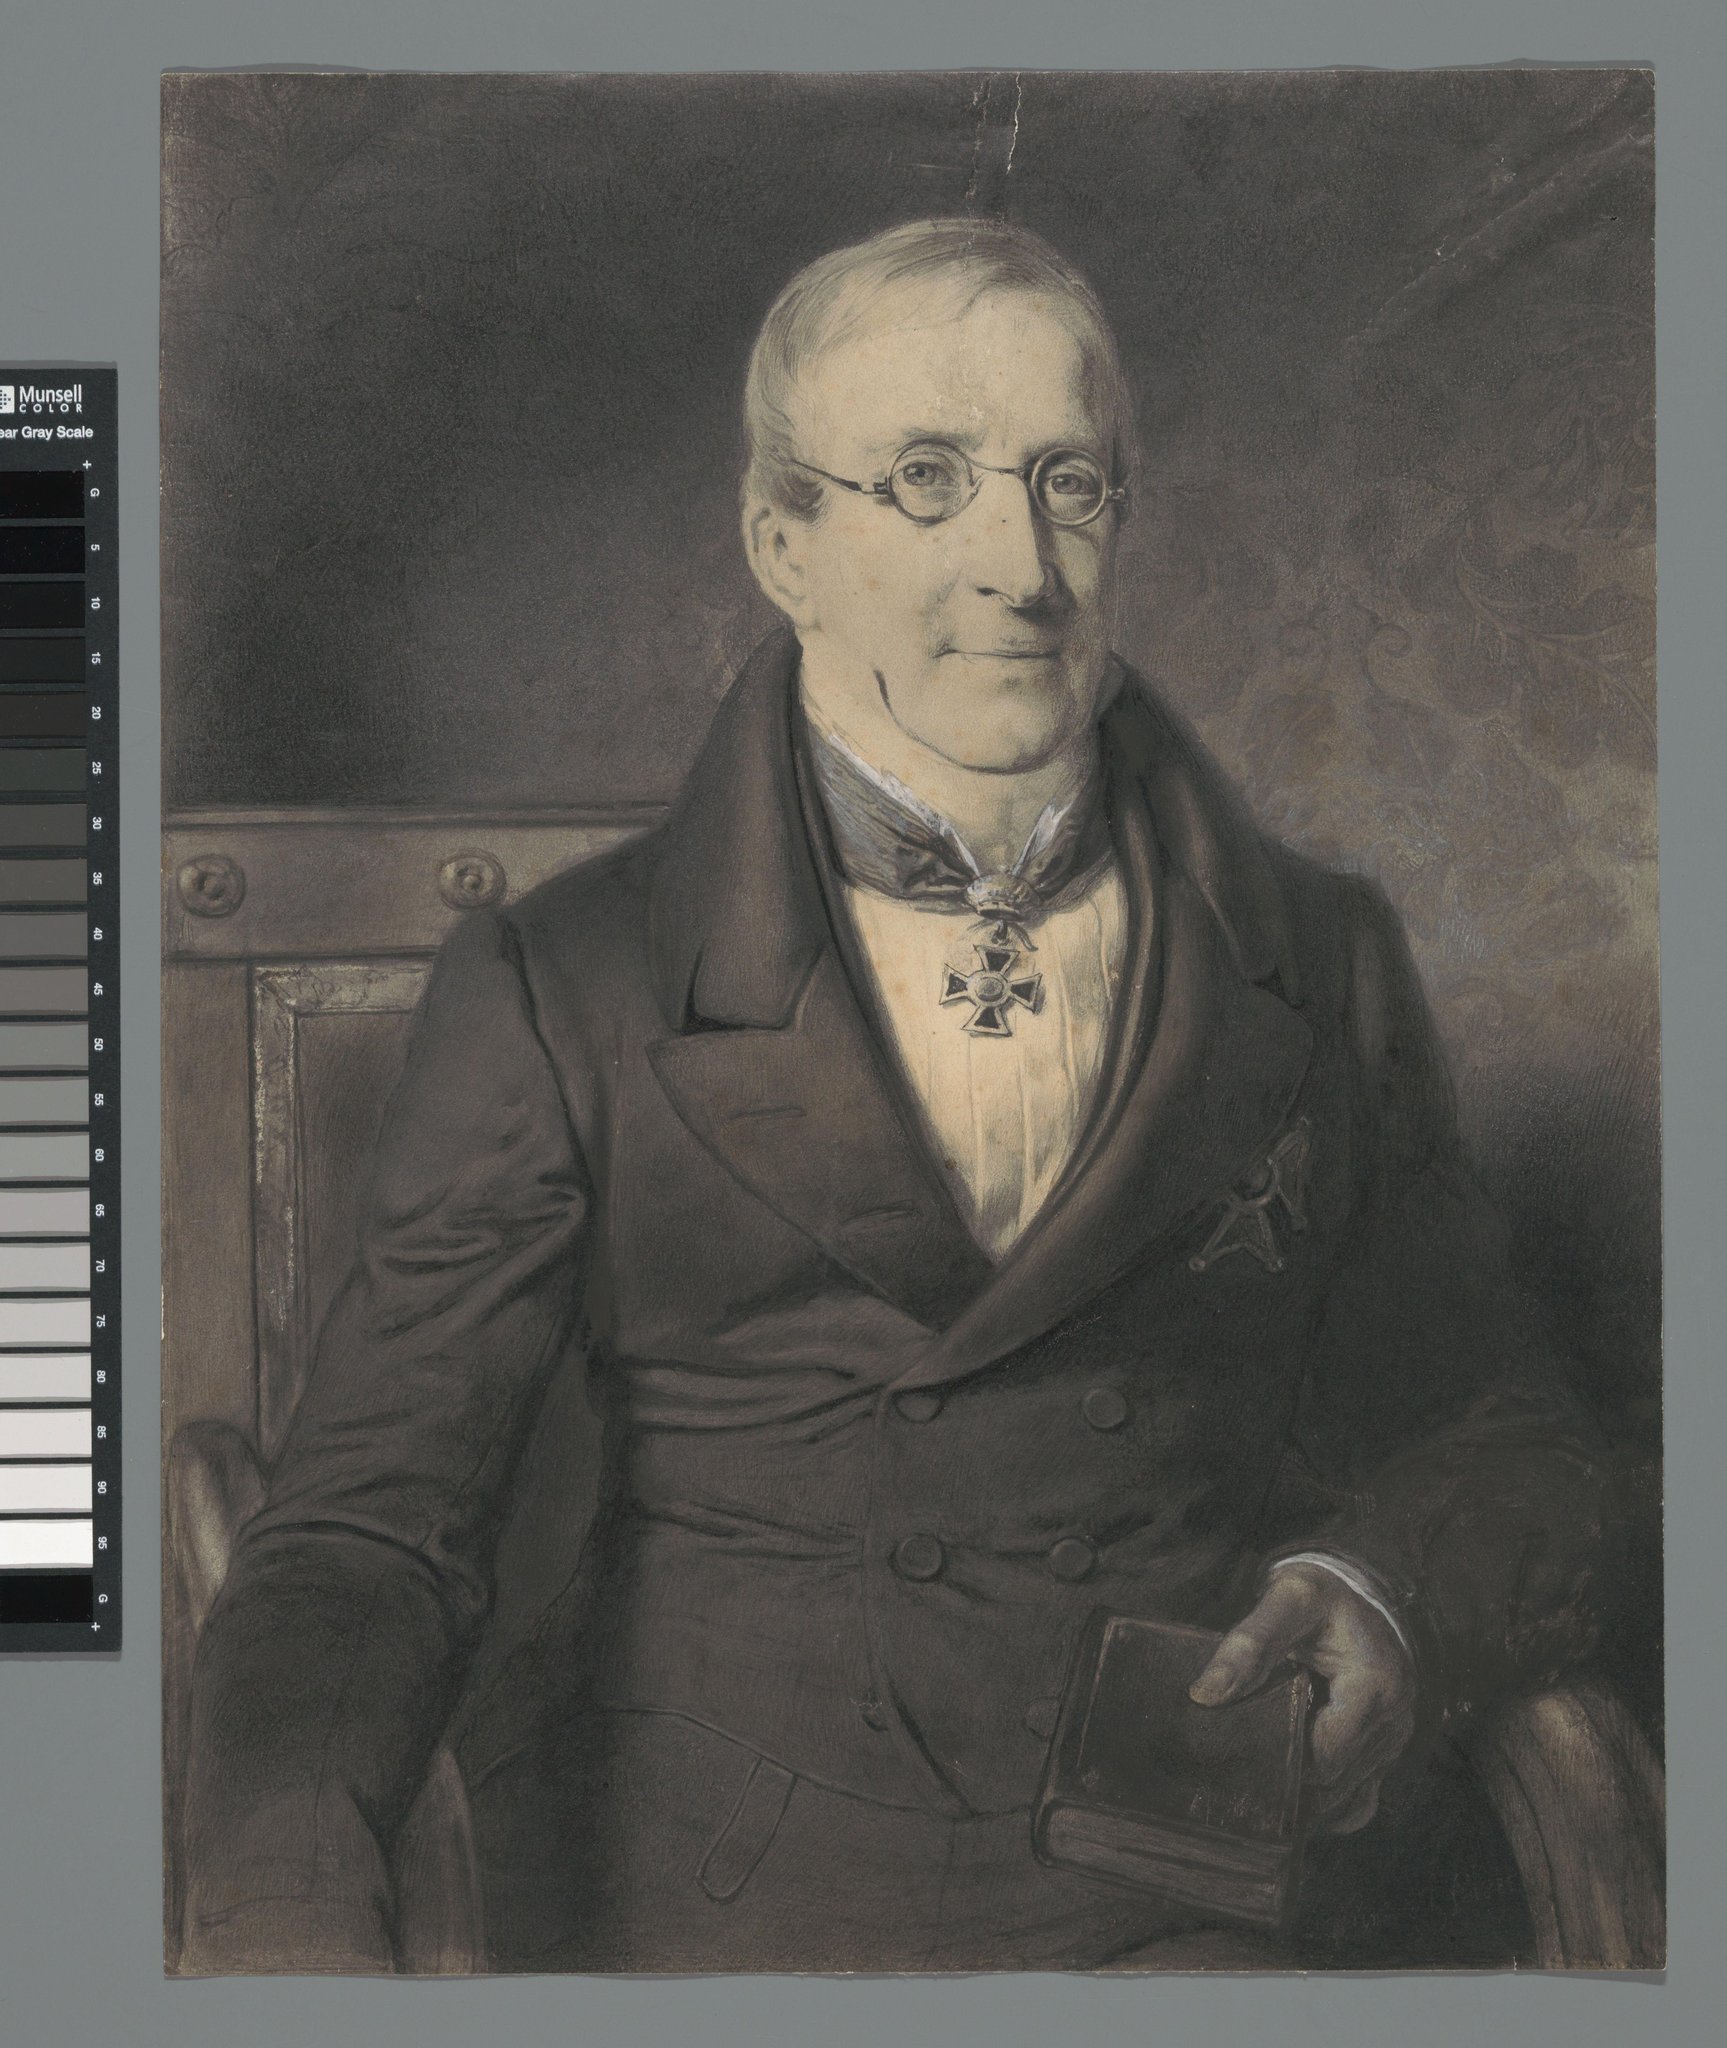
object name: drawing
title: Portret van een man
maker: l.a. vinkens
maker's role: draughtsman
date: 1835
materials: chalk, ink, paper, pencil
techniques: brush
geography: netherlands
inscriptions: date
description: Portret van een man, halve figuur frontaal, zittend in een stoel, hoofd iets naar rechts. Om de nek en op de borst een orde in de vorm van een kruis, in de linkerhand een boek. De man is kalend en draagt een rond brilletje.